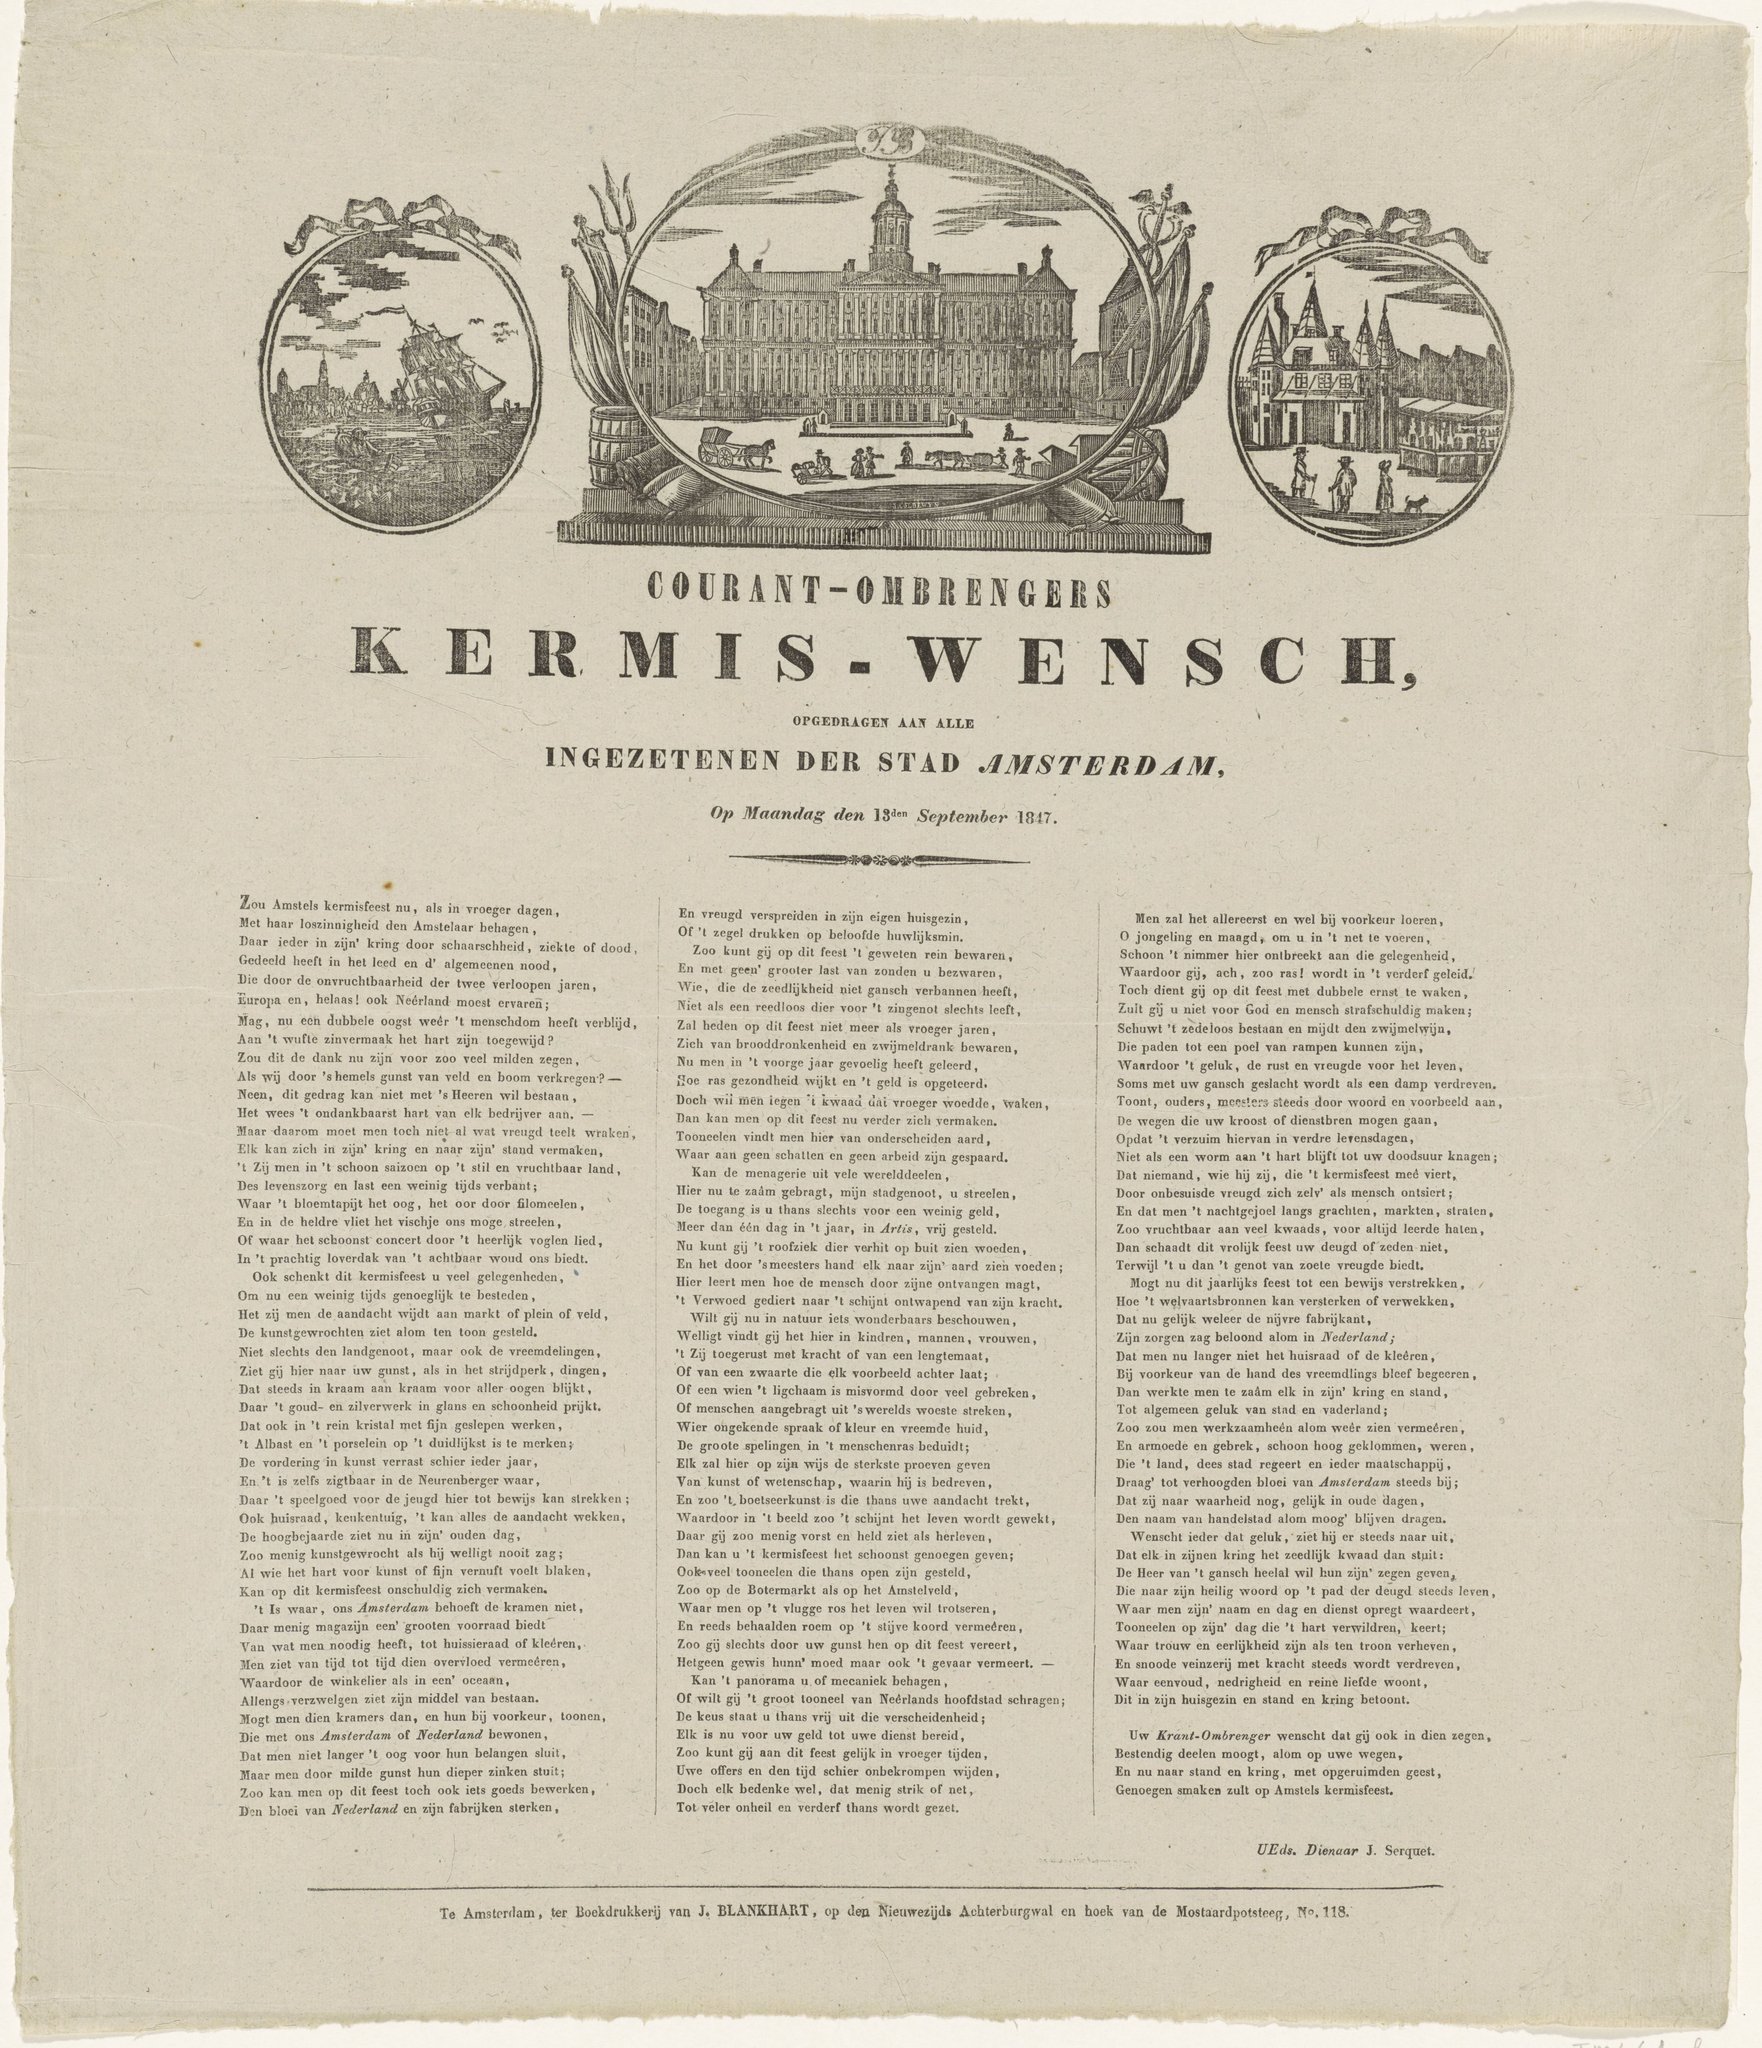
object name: print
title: Courant-ombrengers Kermis-Wensch (...) 1847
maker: jacob coldewijn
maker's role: print maker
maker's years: 1796-1855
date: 1847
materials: paper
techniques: letterpress printing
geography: amsterdam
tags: street, royal palace of amsterdam, amsterdam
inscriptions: collector's mark: Lugt 2228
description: Kermisprent namens de ombrengers van couranten (krantenbezorgers) te Amsterdam, 13 september 1847. Bovenaan drie medaillons met centraal een gezicht op het Paleis op de Dam, links een zeilschip op het IJ, rechts de Nieuwmarkt met de Waag. Onderaan een gedicht in drie kolommen. Van de courantombrenger: J. Serquet.